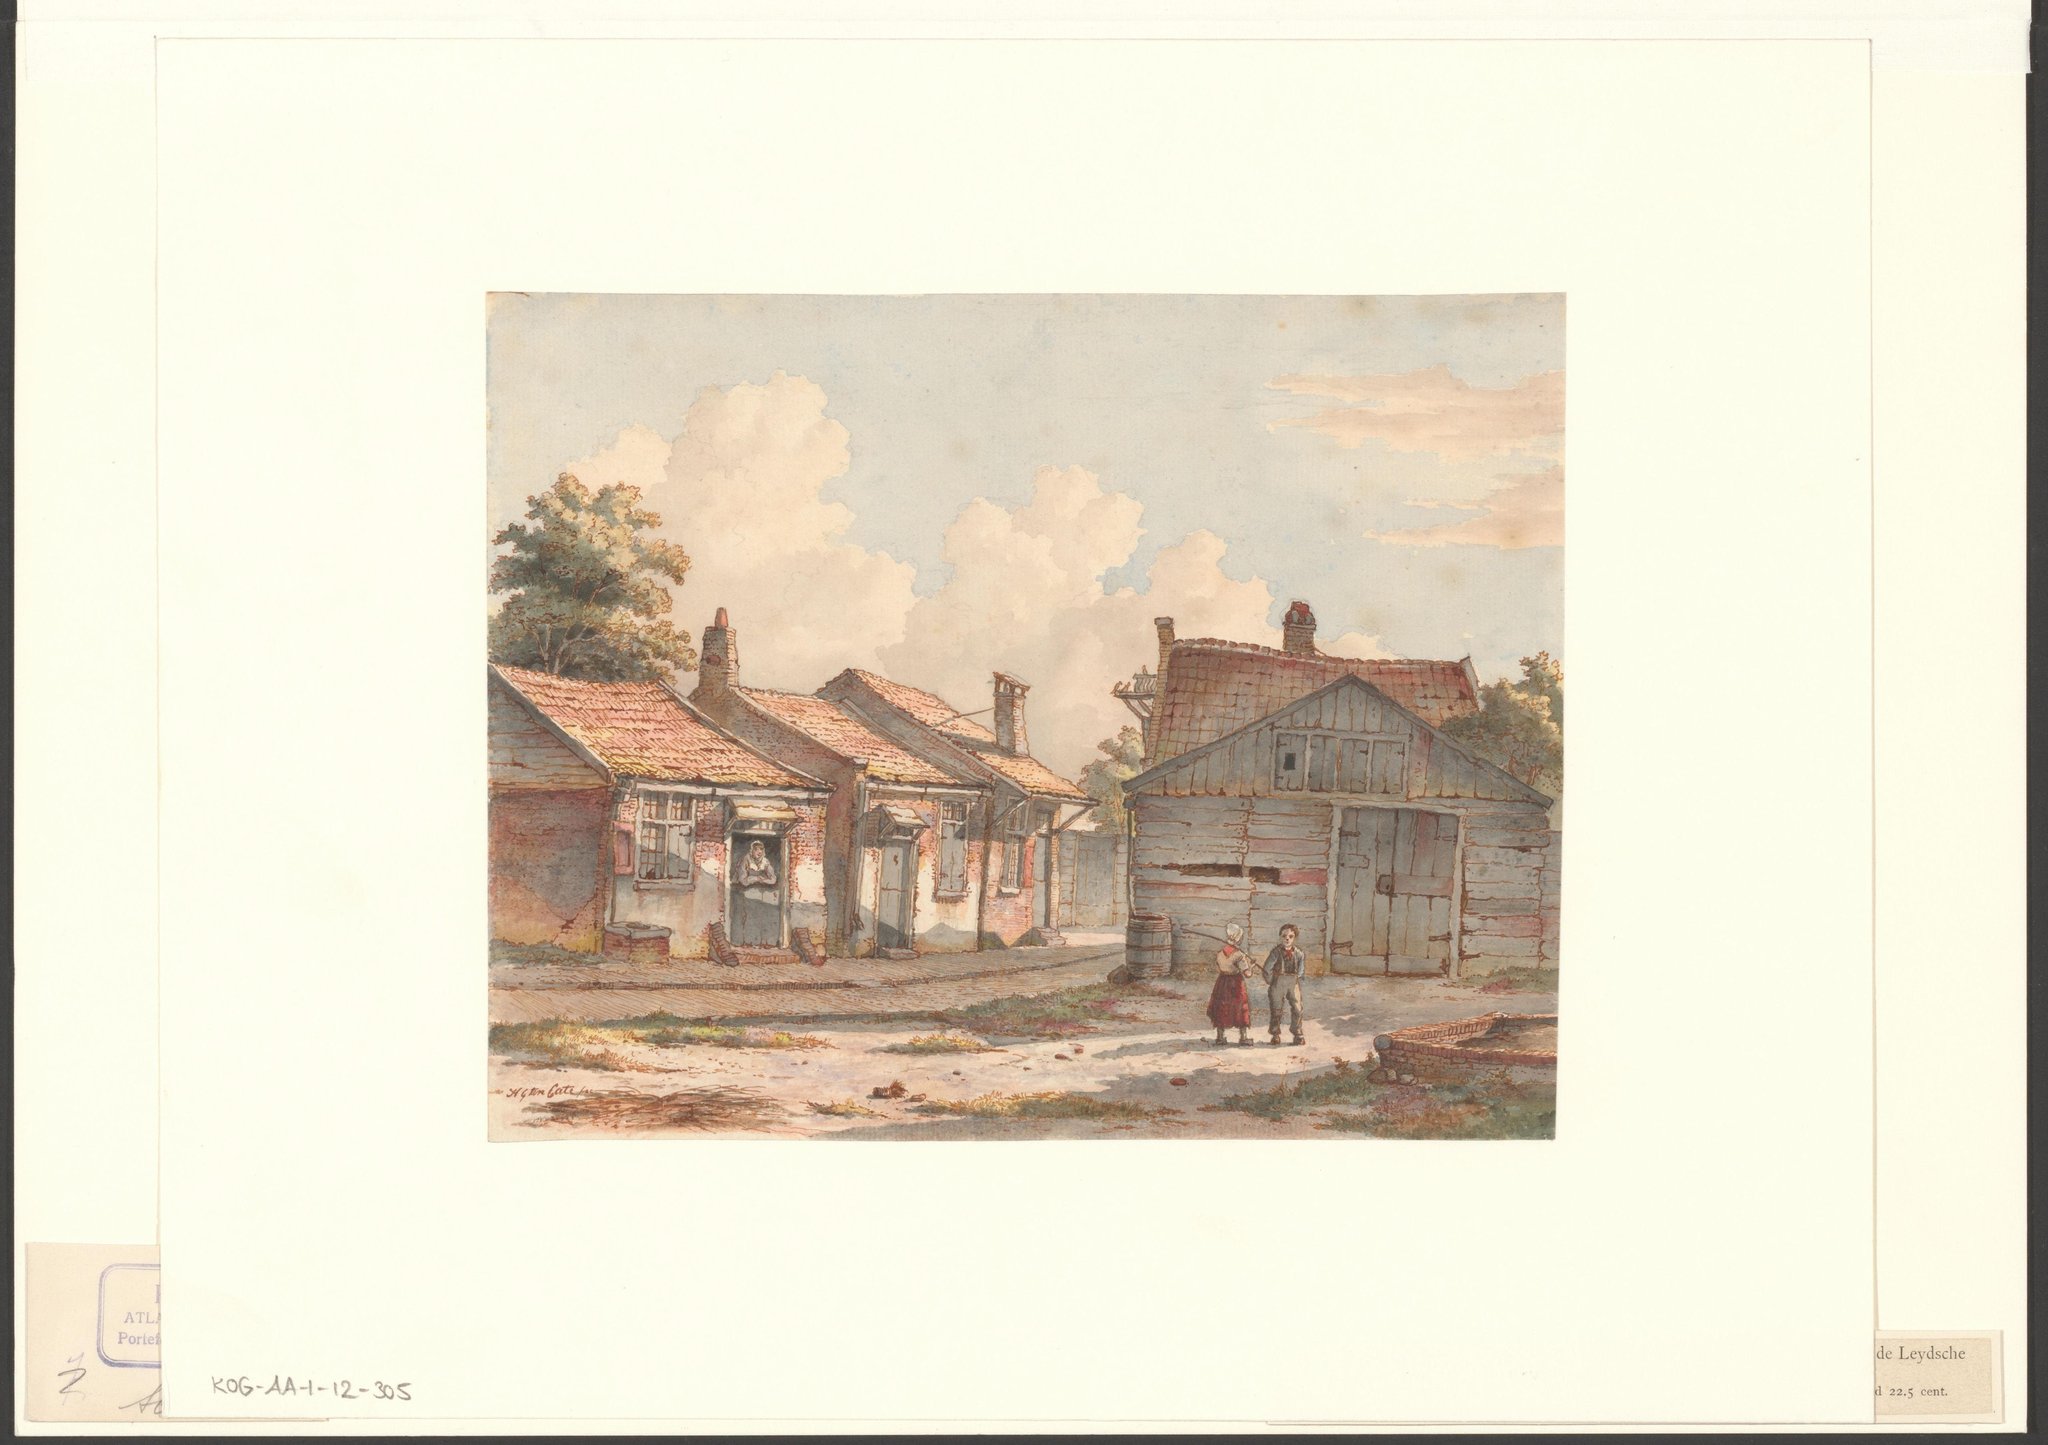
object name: drawing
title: Gezicht op enkele huizen aan de voet van molen De Roomolen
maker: hendrik gerrit ten cate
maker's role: draughtsman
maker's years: 1803-1856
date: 1833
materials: ink, paper, pencil, watercolor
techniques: brush, pen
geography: amsterdam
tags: city-view in general; 'veduta', road, path, farm or solitary house in landscape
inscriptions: inscription: ‘Port. 12-305’, signature: ‘HG ten Cate fec’, collector's mark: ‘12’ Lugt 1641b, inscription: ‘147 Het zoogenaamde (...) breed 22.5 cent.’, signature: ‘HG ten Cate fec’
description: Onderwerpsrubriek binnen de Atlas Amsterdam: Sarphatistraat, Schans.